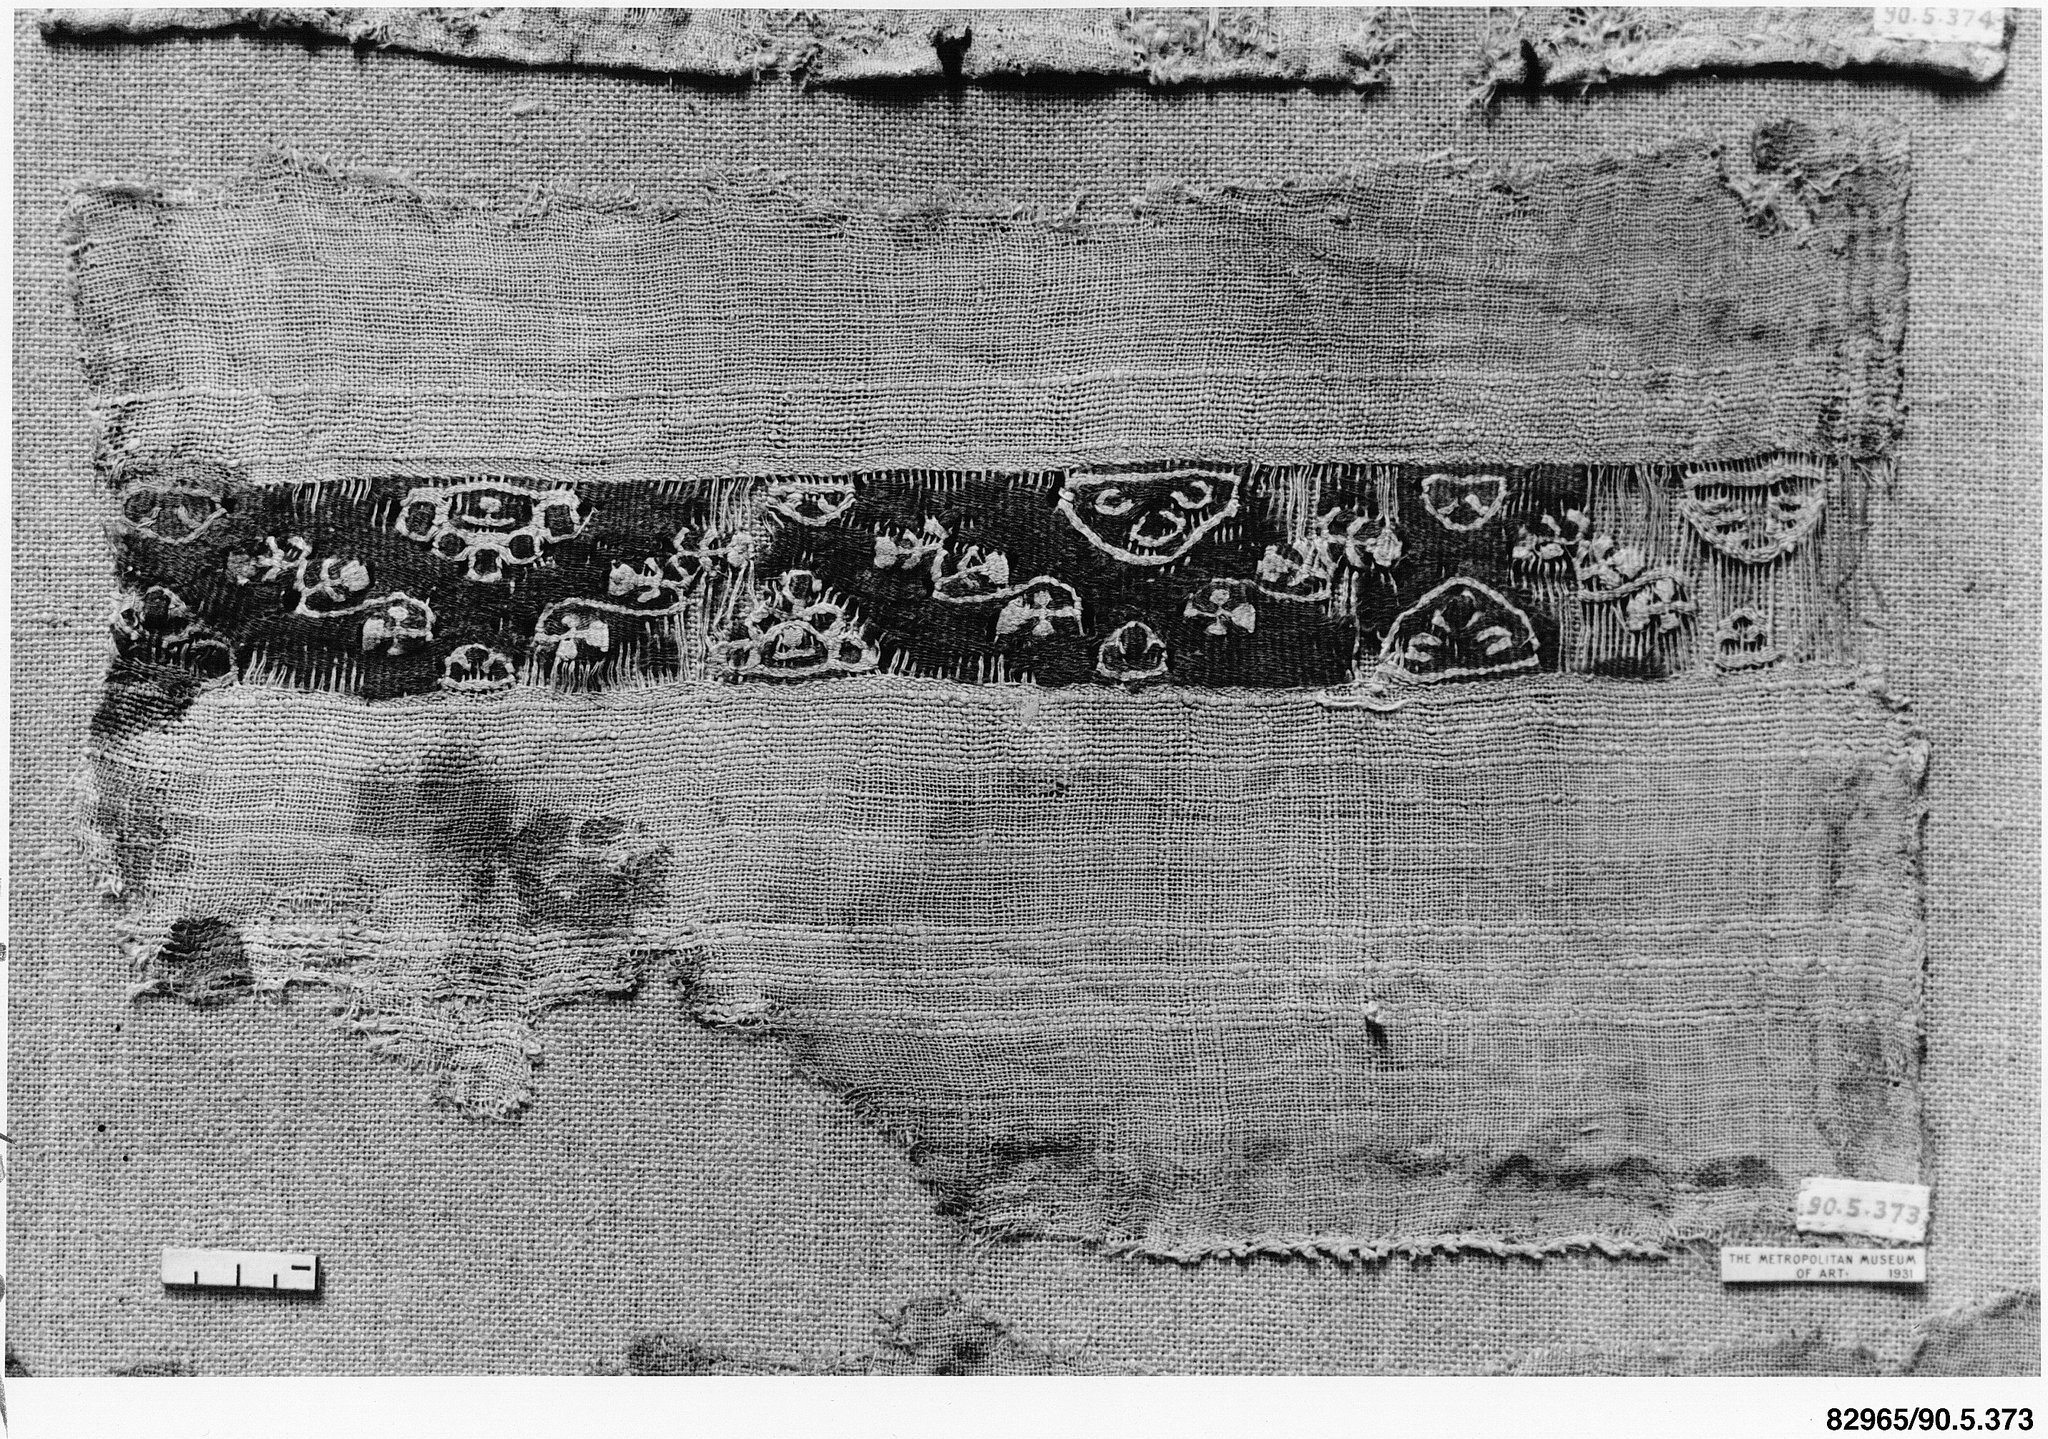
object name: textile fragment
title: Fragment of a Tunic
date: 401-600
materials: linen, wool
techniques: weave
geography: egypt